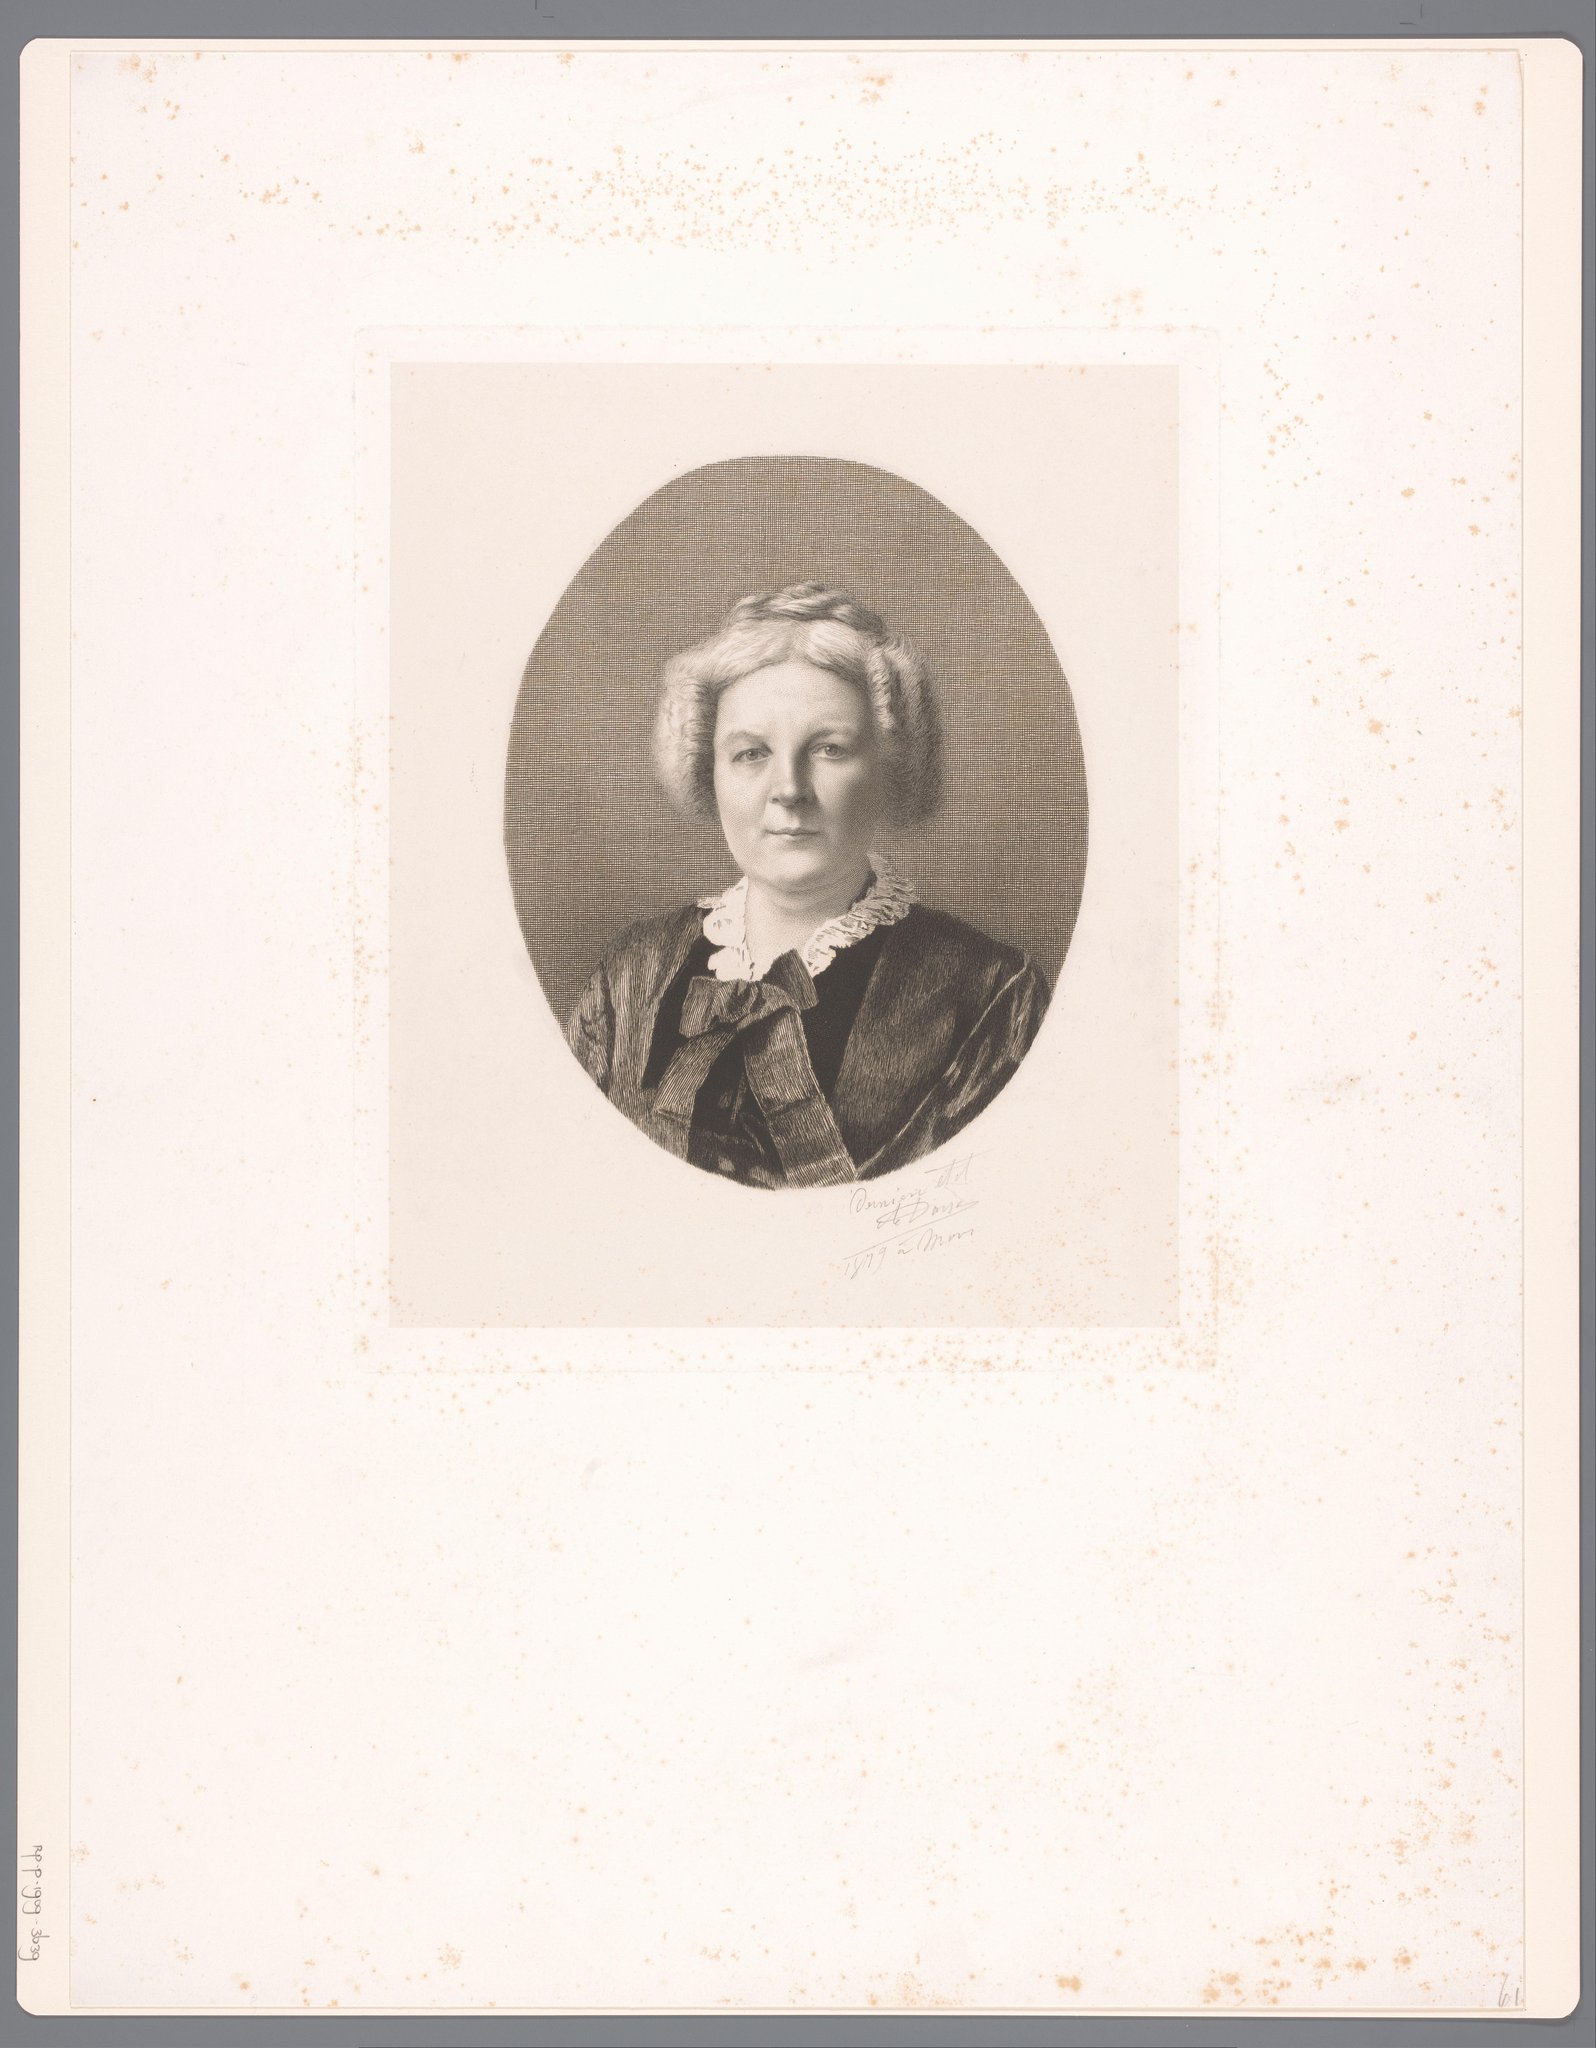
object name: print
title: Portret van een onbekende dame, mevrouw Sainctelette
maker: auguste danse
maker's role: print maker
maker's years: 1829-1929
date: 1879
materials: paper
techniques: drypoint, etching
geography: bergen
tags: anonymous historical person portrayed alone - bb - woman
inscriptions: collector's mark: Lugt 2228, annotation: ‘Dernier etat’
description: De naam Sainctelette is gebaseerd op een potloodaantekening in de ondermarge van een eerdere staat van deze prent.